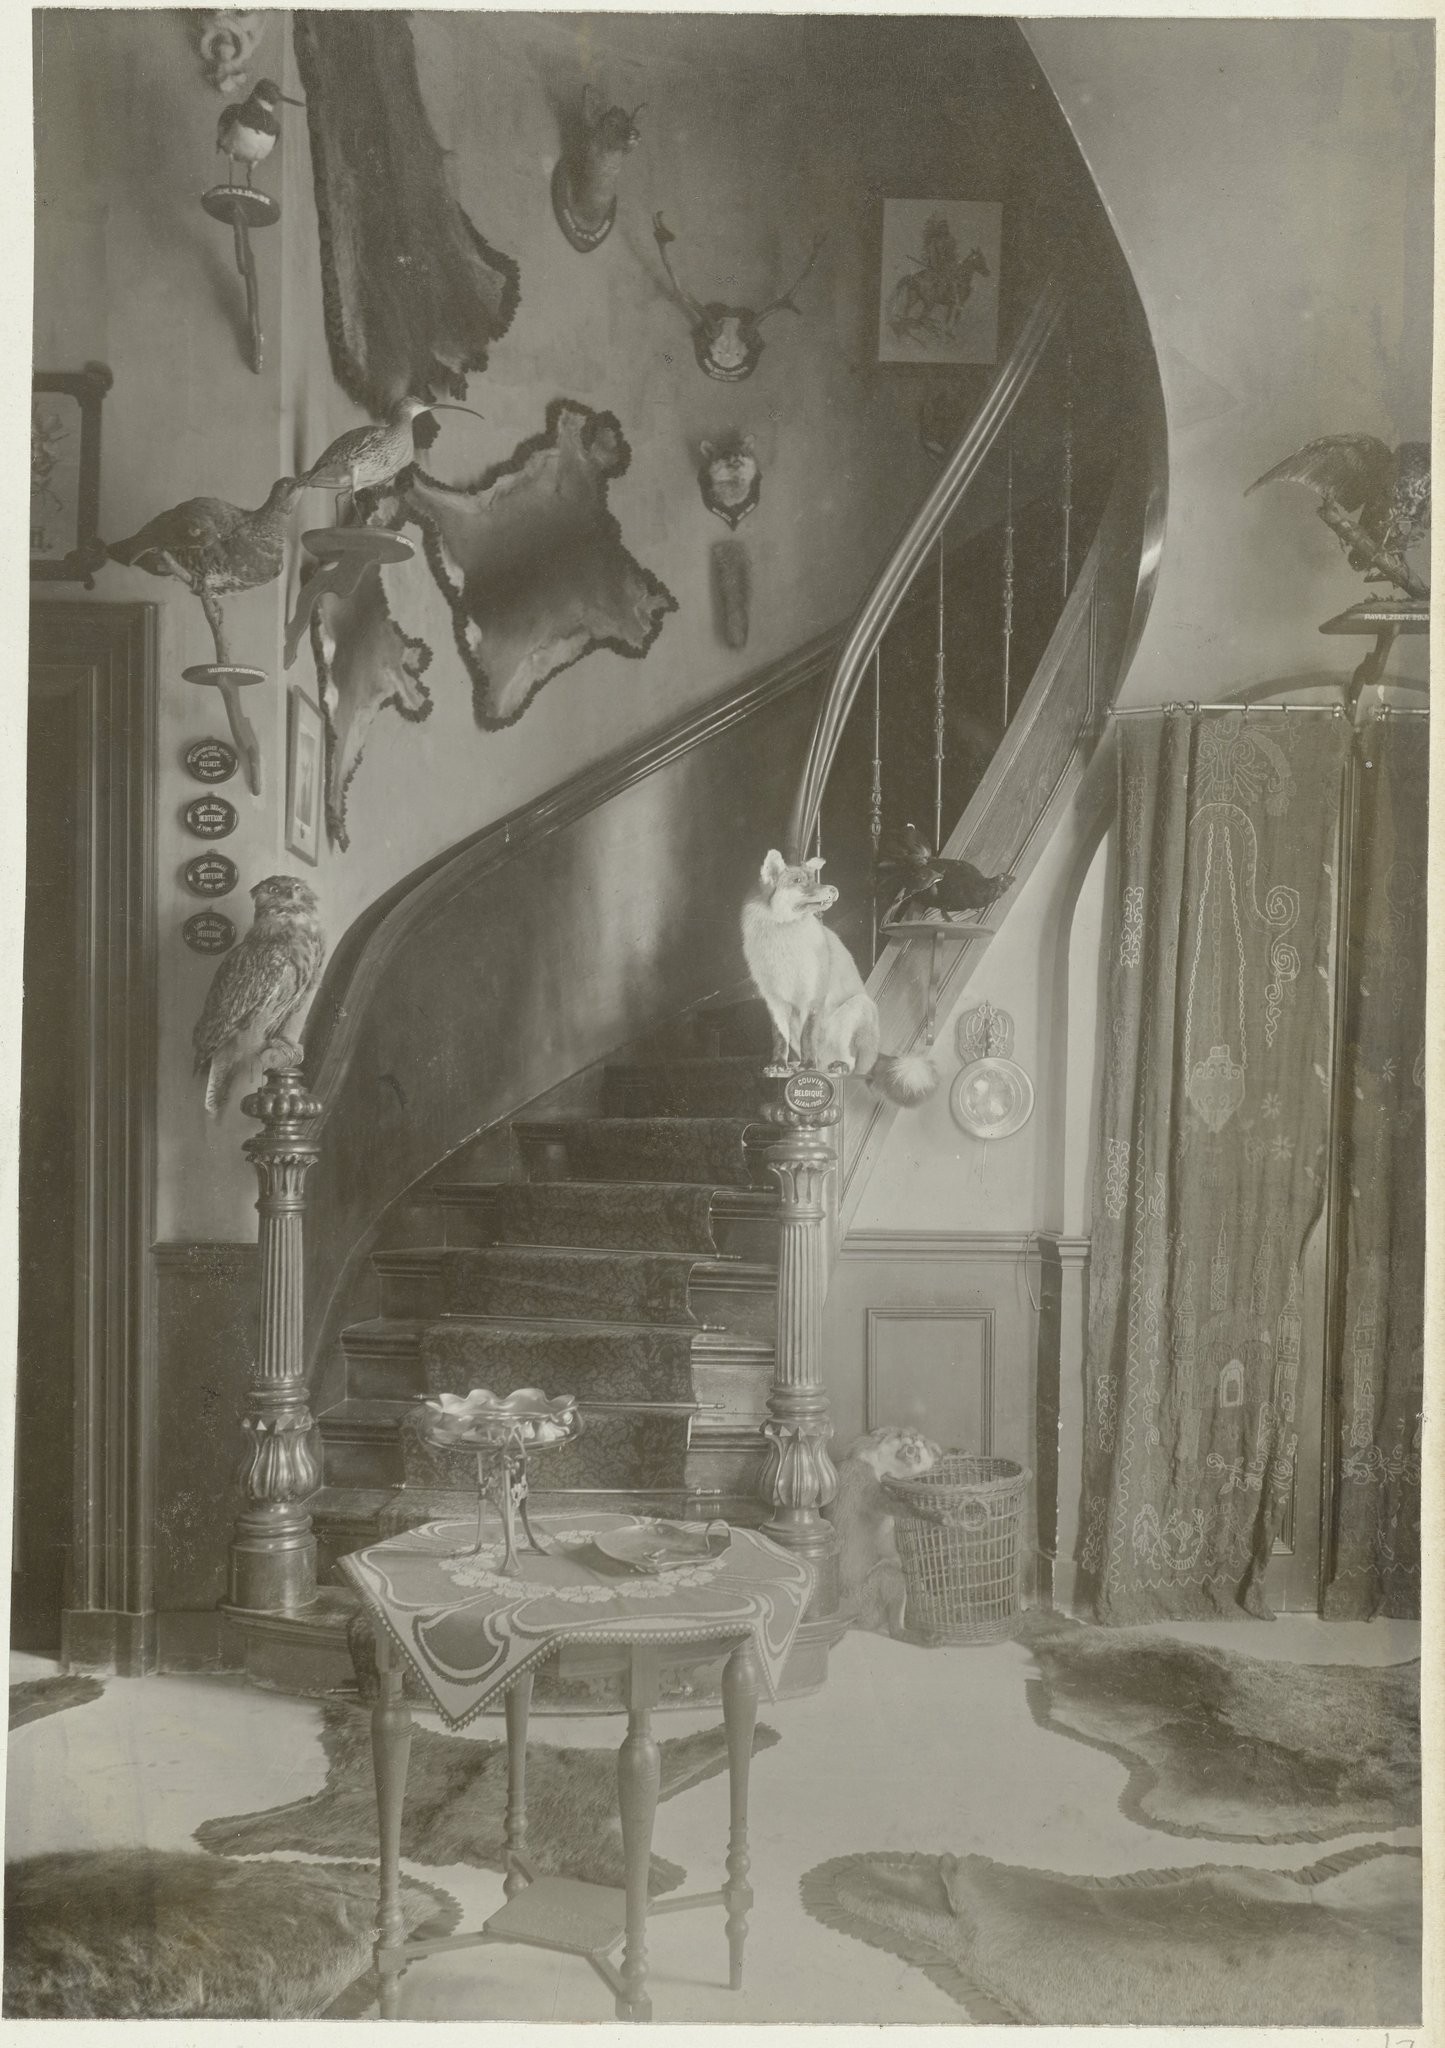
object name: photograph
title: Trap in de hal van landhuis De Wildbaan met jachttrofeeën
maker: henry pauw van wieldrecht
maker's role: fotograaf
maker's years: 1863-1912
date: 1903-1907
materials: paper, photographic support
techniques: gelatin silver print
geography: netherlands